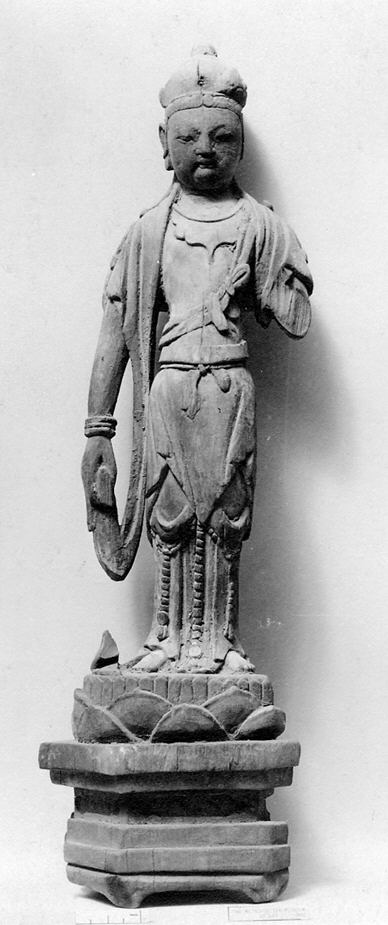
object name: statuette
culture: chinese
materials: wood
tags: men